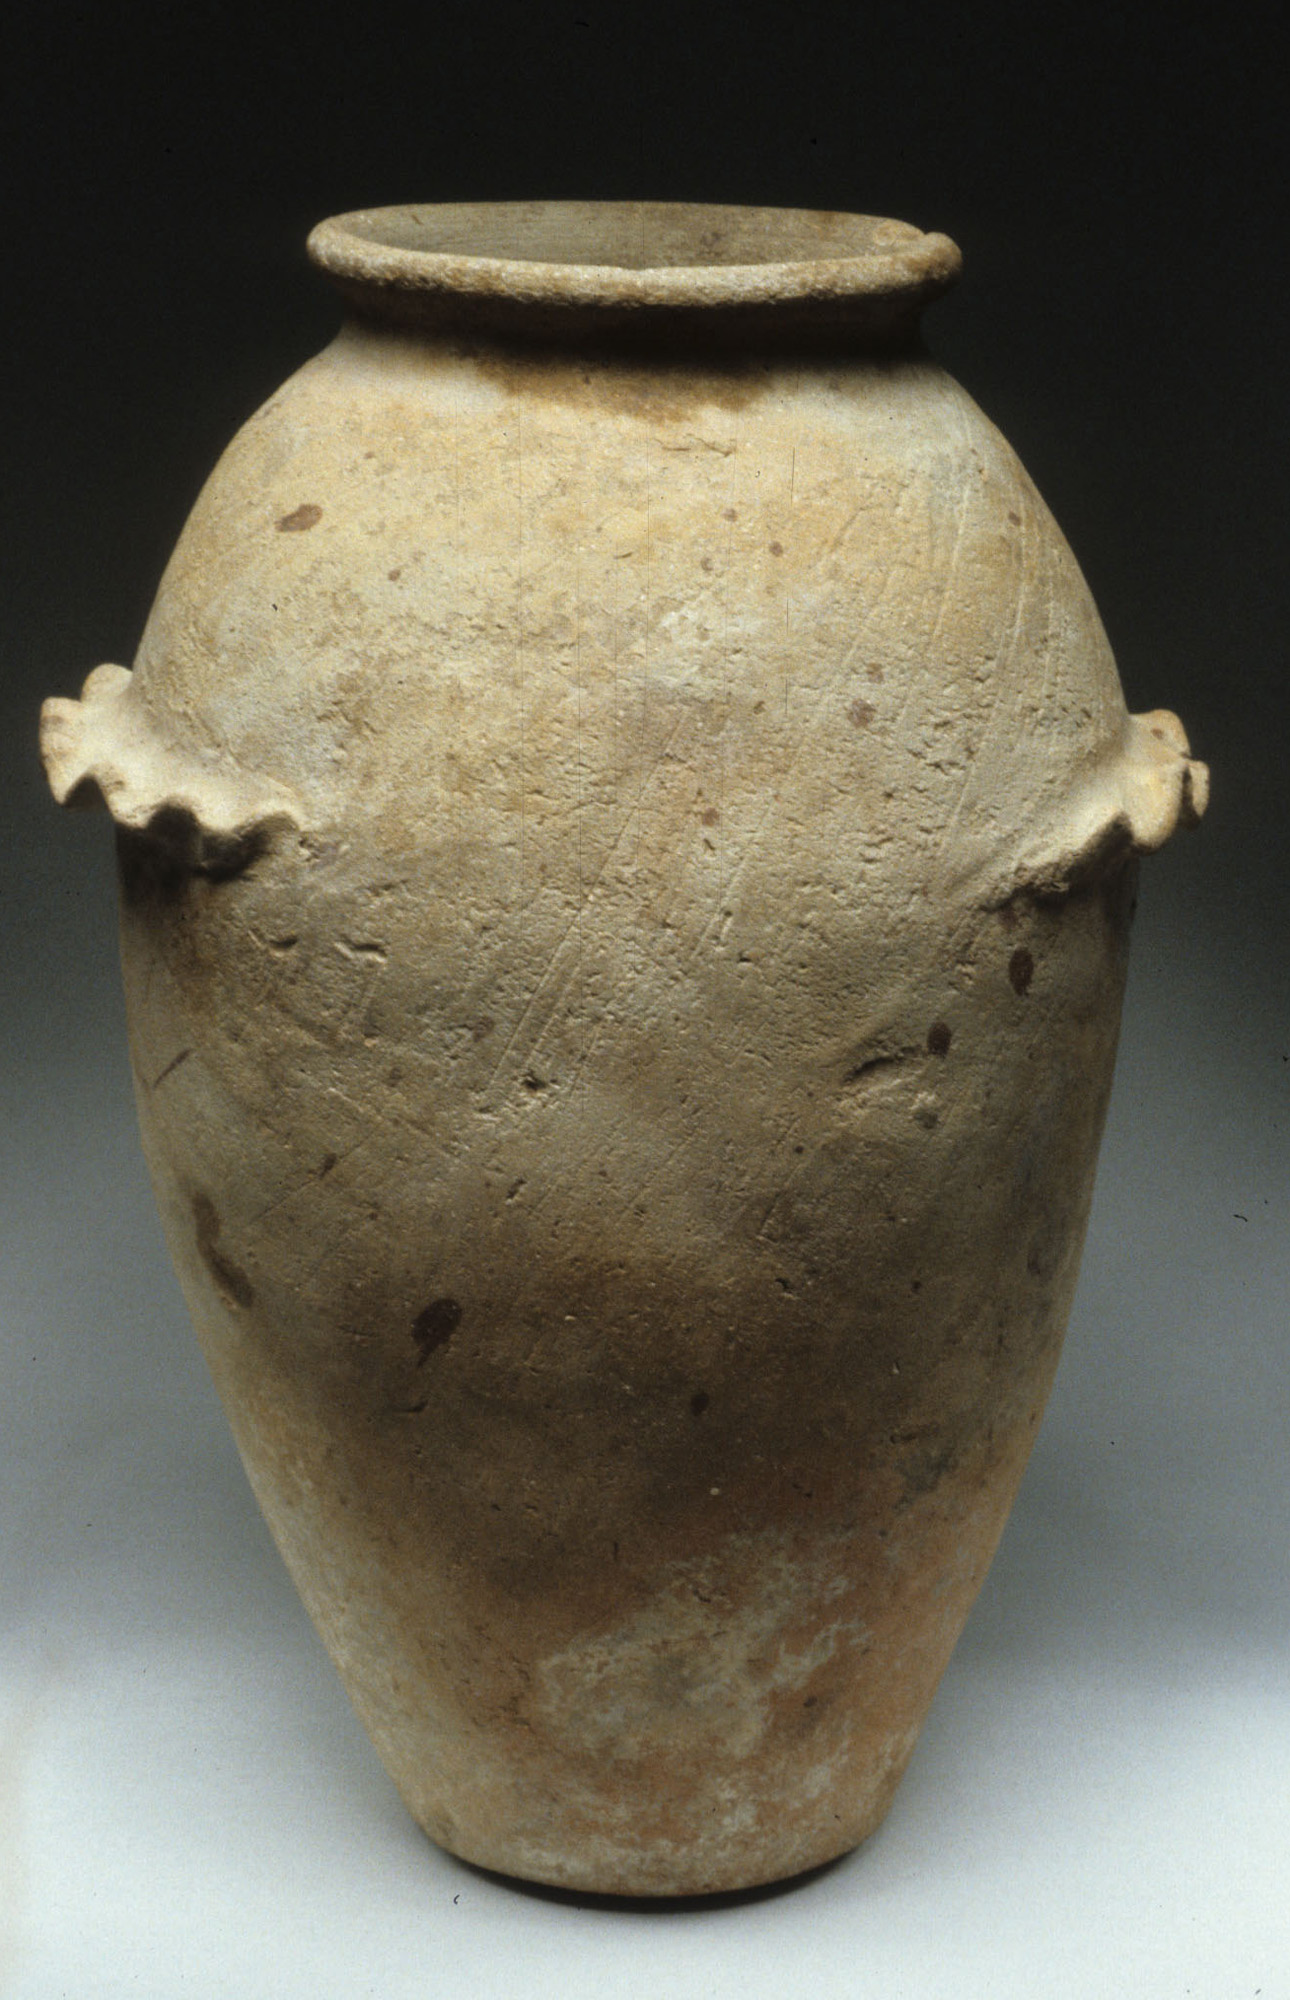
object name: jar, wavy handled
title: Wavy-handled ware jar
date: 3500 BCE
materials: pottery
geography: egypt